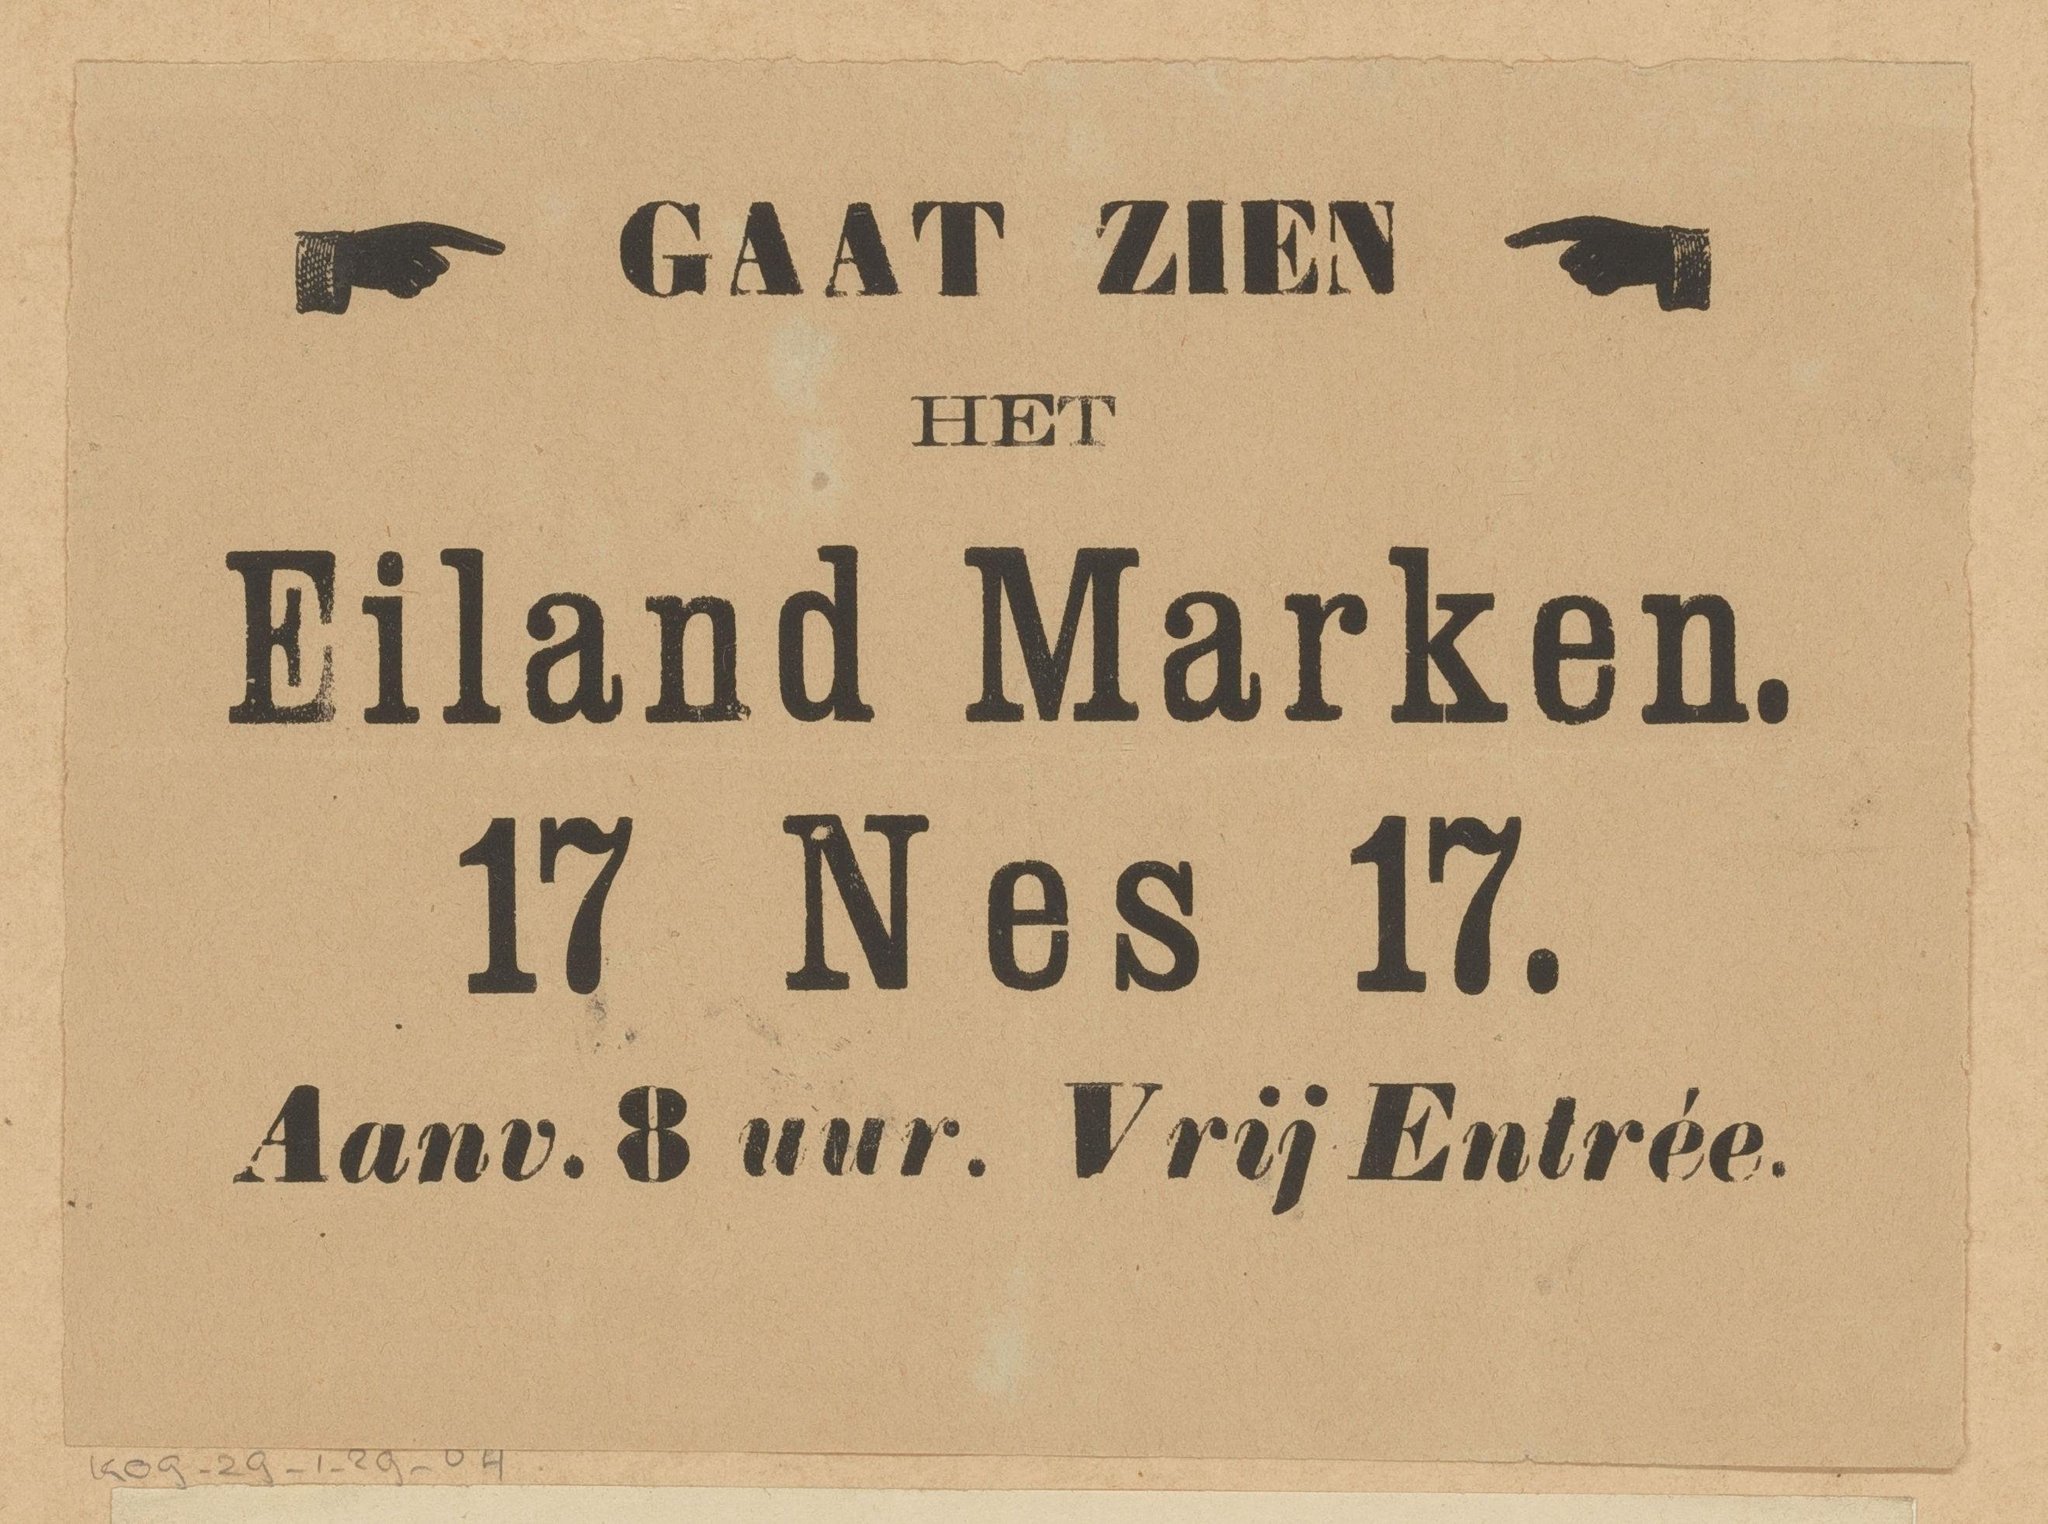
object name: poster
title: Aankondiging van een toneelstuk met de titel Het Eiland Marken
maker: Anonymous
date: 1800-1899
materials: paper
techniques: letterpress printing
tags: theatre, theatrical performance, amsterdam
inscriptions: stamp, collector's mark: Lugt 1641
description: Aankondiging van een toneelstuk met de titel Het Eiland Marken, te zien op Nes 17. Onderwerpsrubrieken binnen de Atlas Zeden en Gewoonten: Zeden en gewoonten in engeren zin, Volksleven, Uitspanningslokalen, Het Panopticum en degelijke.